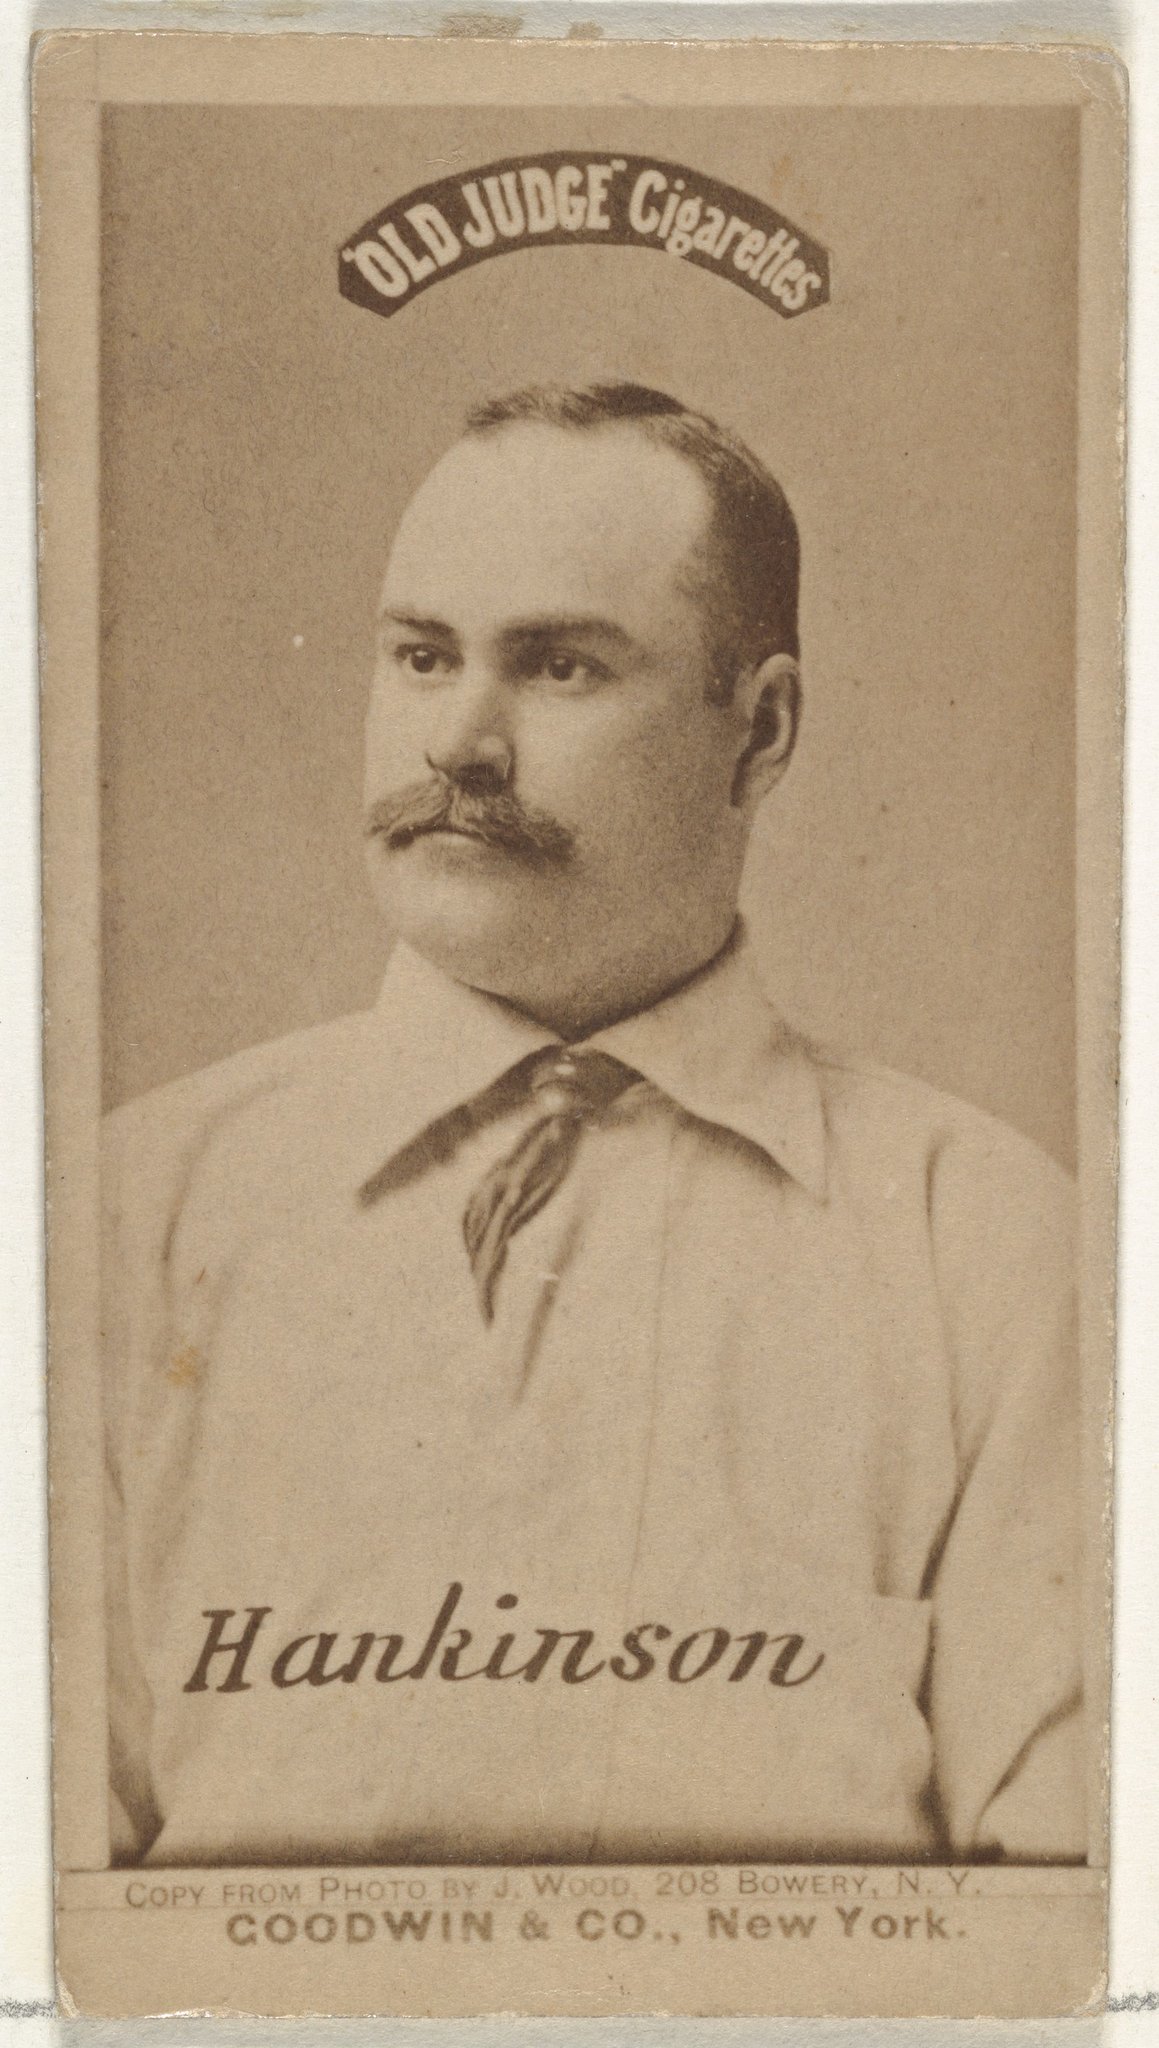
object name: baseball card, photograph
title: Frank Edward Hankinson, from the Old Judge series (N172) for Old Judge Cigarettes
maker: goodwin & company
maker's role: publisher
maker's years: 1850-1950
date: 1887-1890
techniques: albumen silver print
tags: men,portraits,baseball,athletes